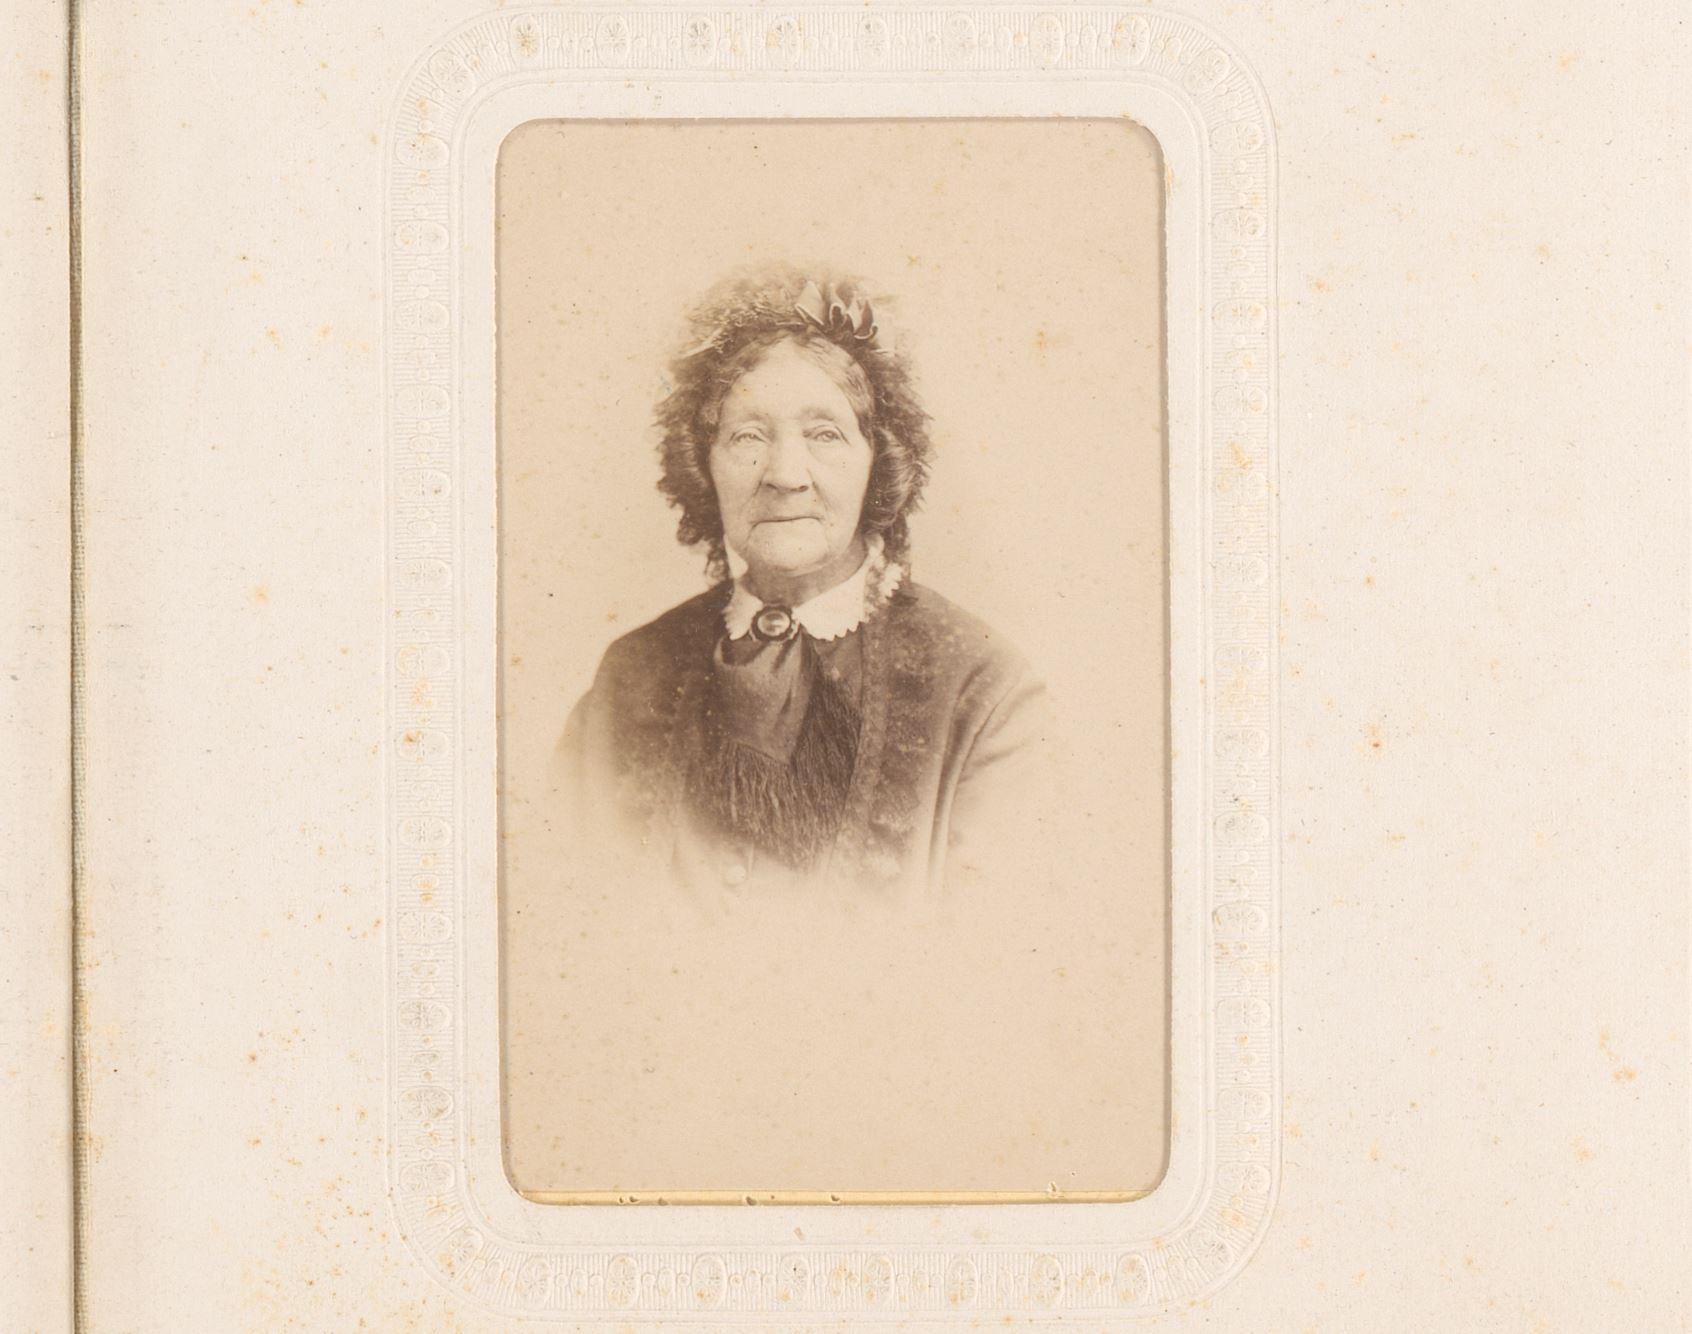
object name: carte de visite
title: Portret van een oude vrouw met muts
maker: Anonymous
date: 1860-1900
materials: cardboard, photographic support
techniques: albumen print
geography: netherlands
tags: historical persons - bb - woman, old woman, head-gear: cap